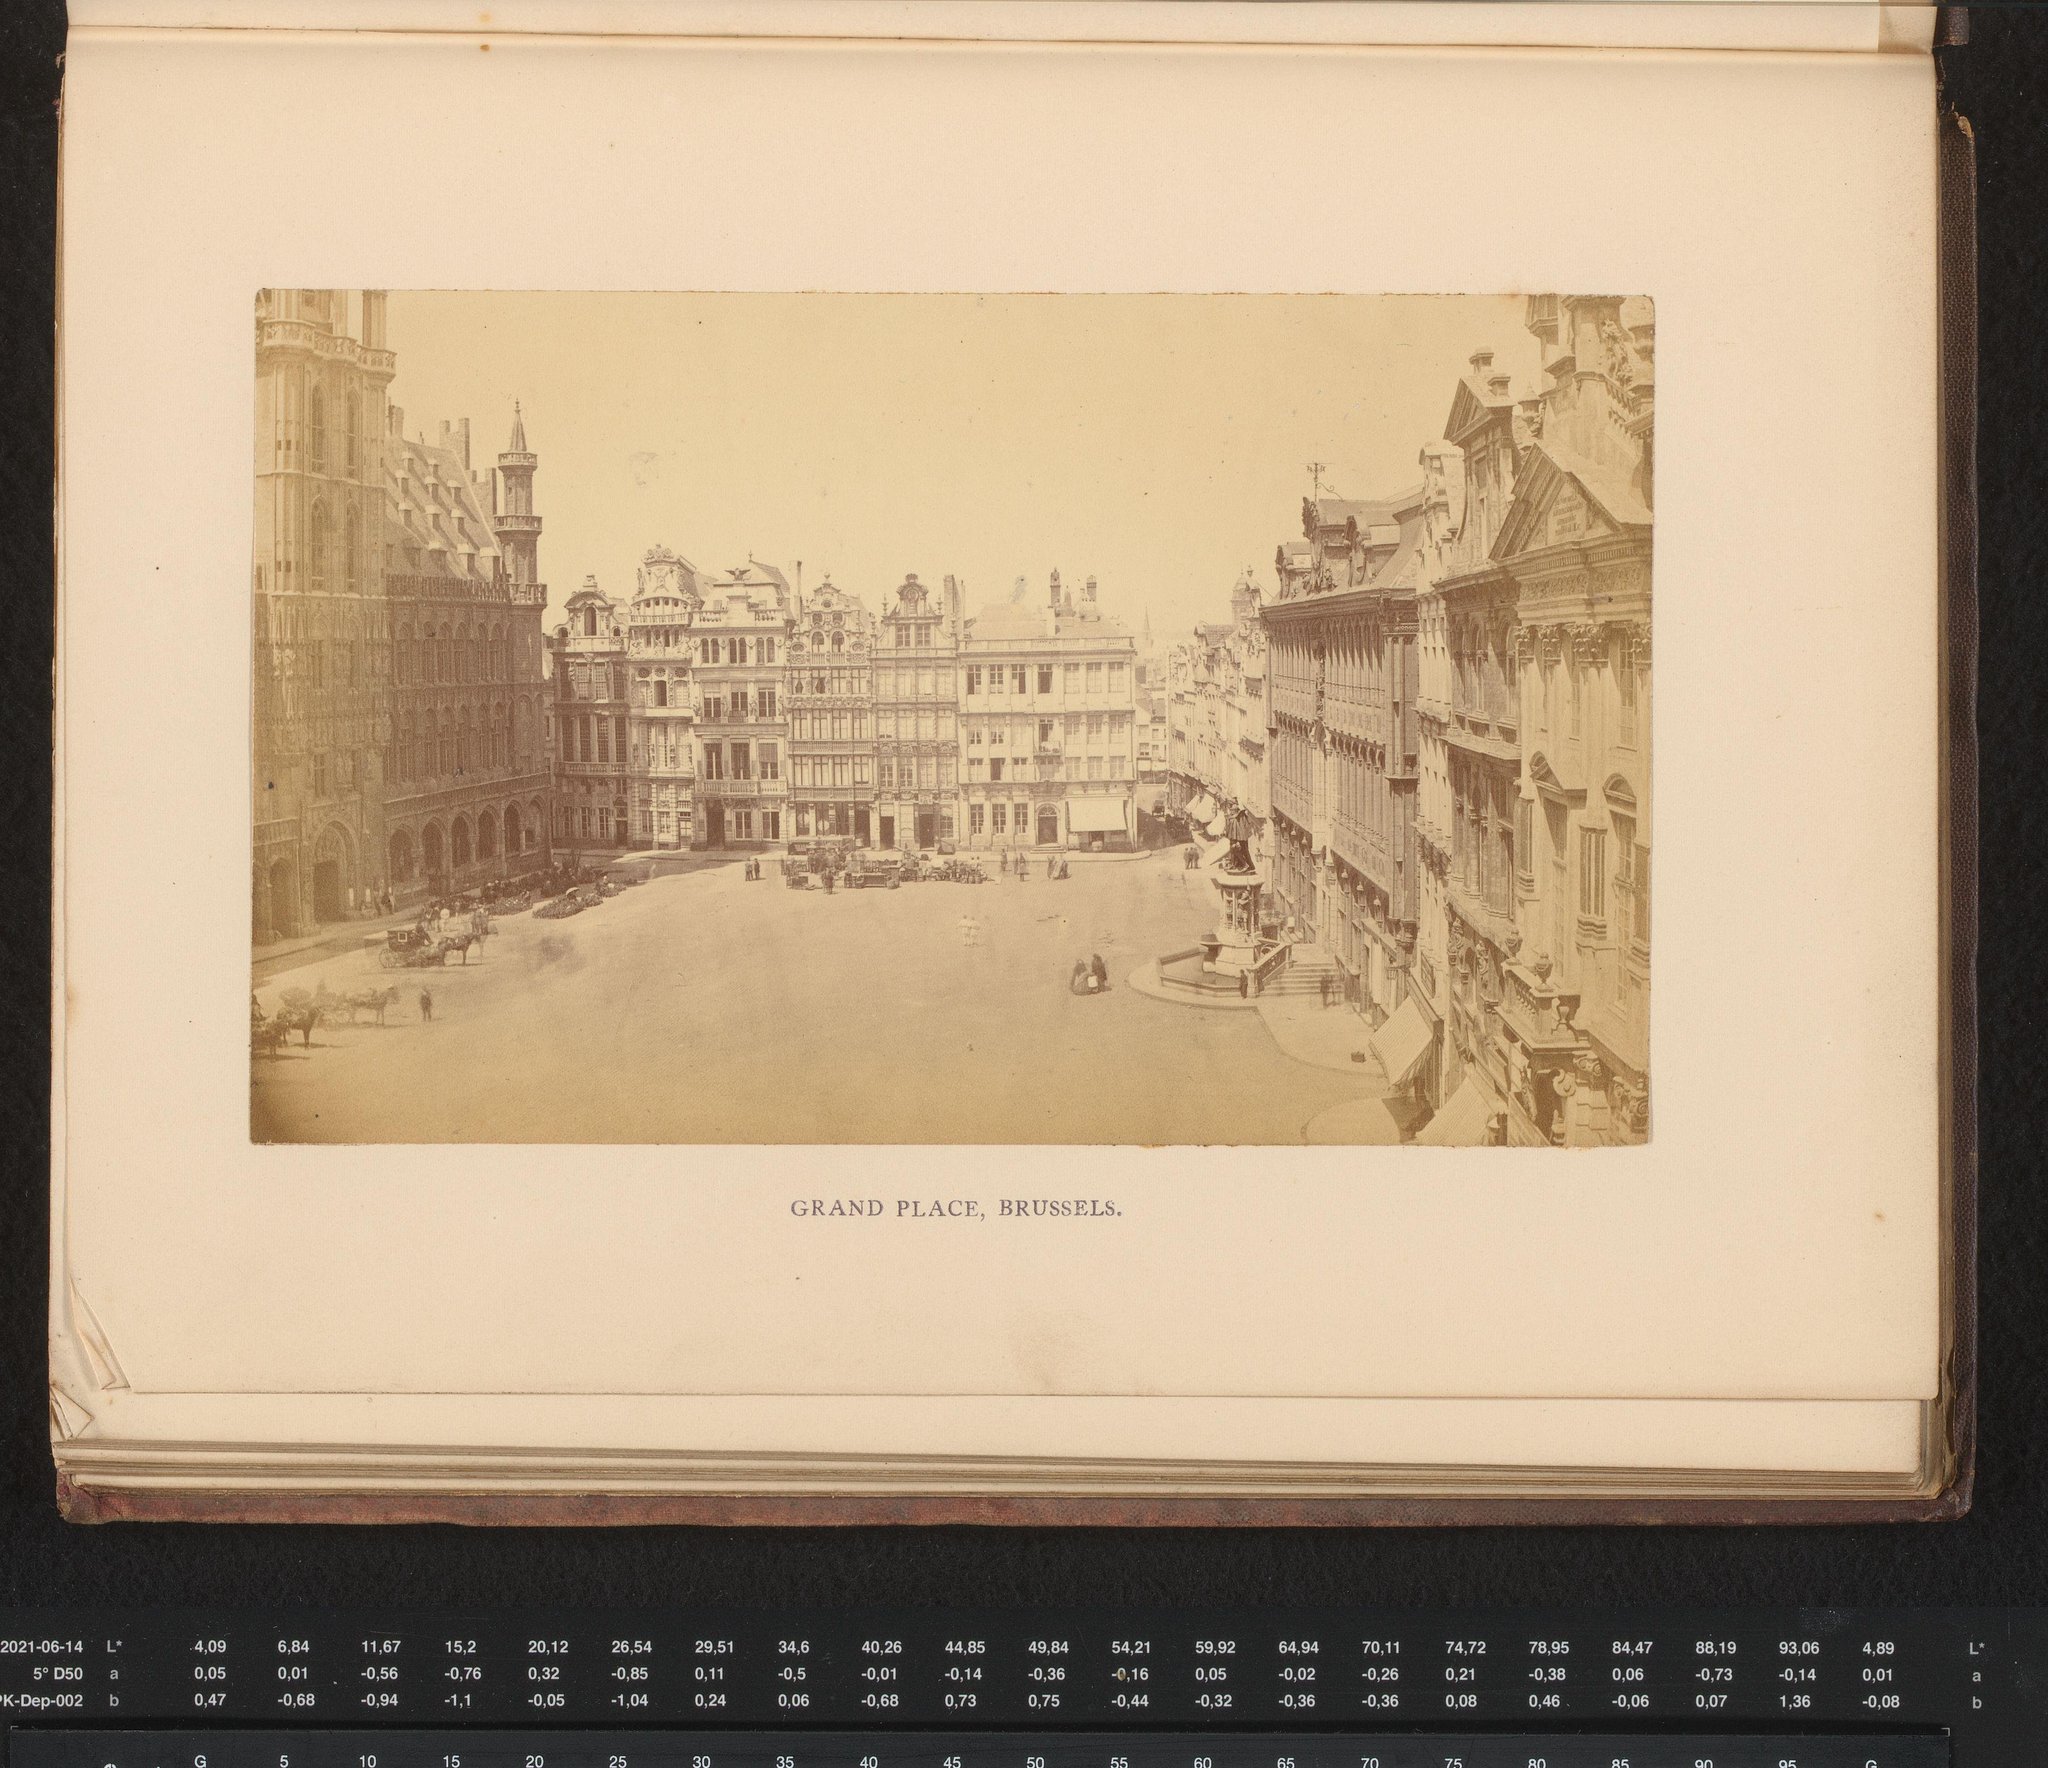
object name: photograph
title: Grande Place, Brussels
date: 1855-1866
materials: paper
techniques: albumen print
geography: brussels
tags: square, place, circus, etc.